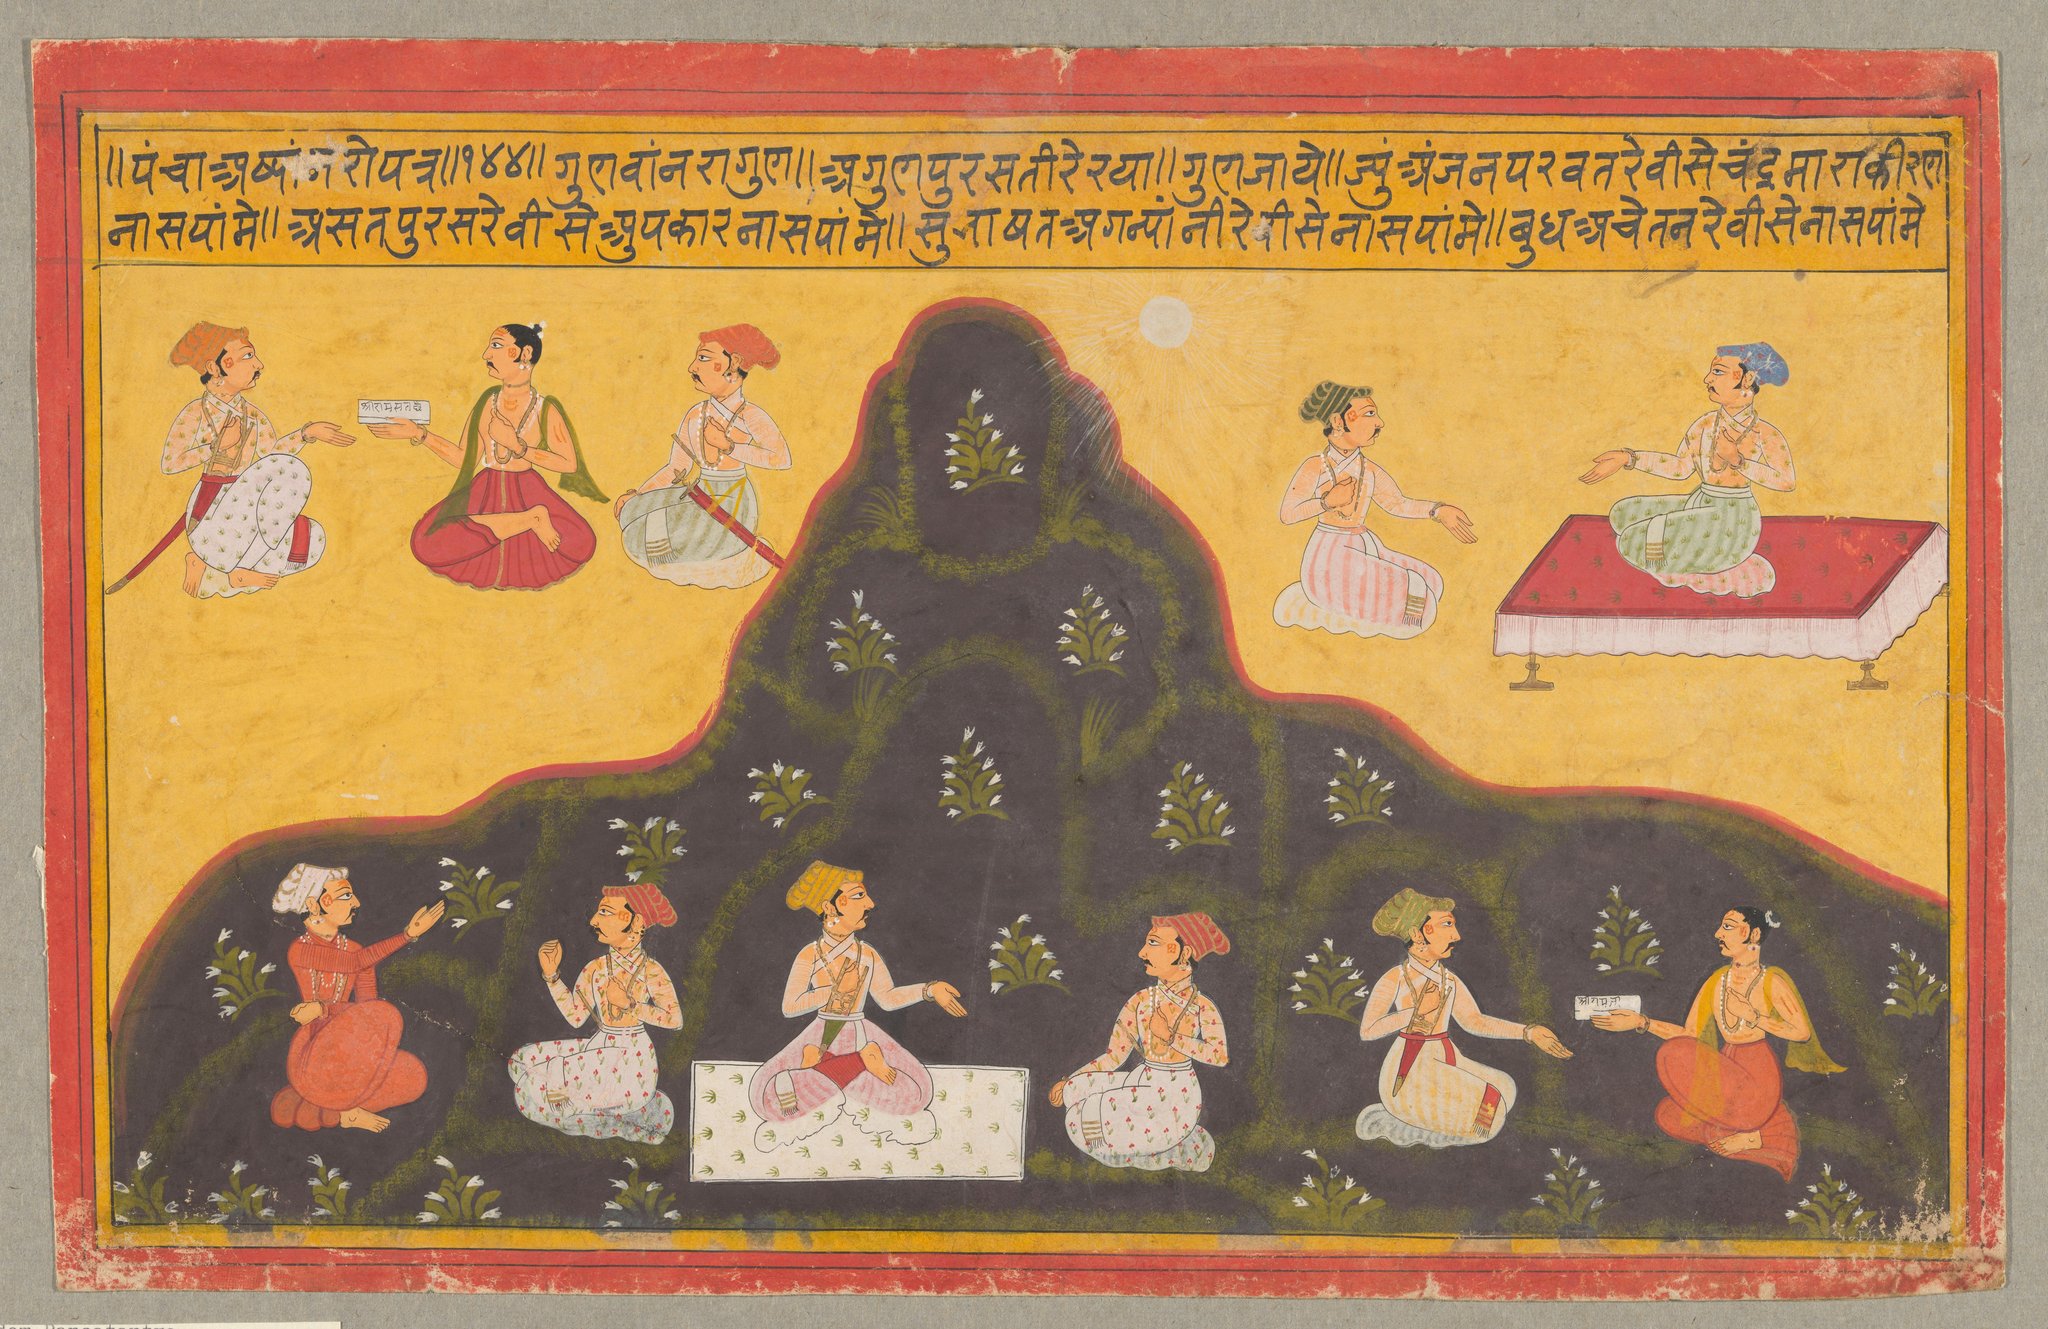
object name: indian miniature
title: Page from a Panchatantra manuscript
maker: Anonymous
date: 1720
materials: paper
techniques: brush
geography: india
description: Mewar Purchased from Maggs Bros., London, 1974 Published in: Oriental Miniatures & Illumination, Bulletin 22, March 1974, no.74 Published in: Dahmen Dallapiccola, A.L. Indische Miniaturen. Malerei der Rajput Staaten, Holle Verlag, Baden Baden, 1976, pl. 34 Exhibited Heidelberg, Indian Painting exhibition at the J. u. E. von Portheim-Stiftung, 1976